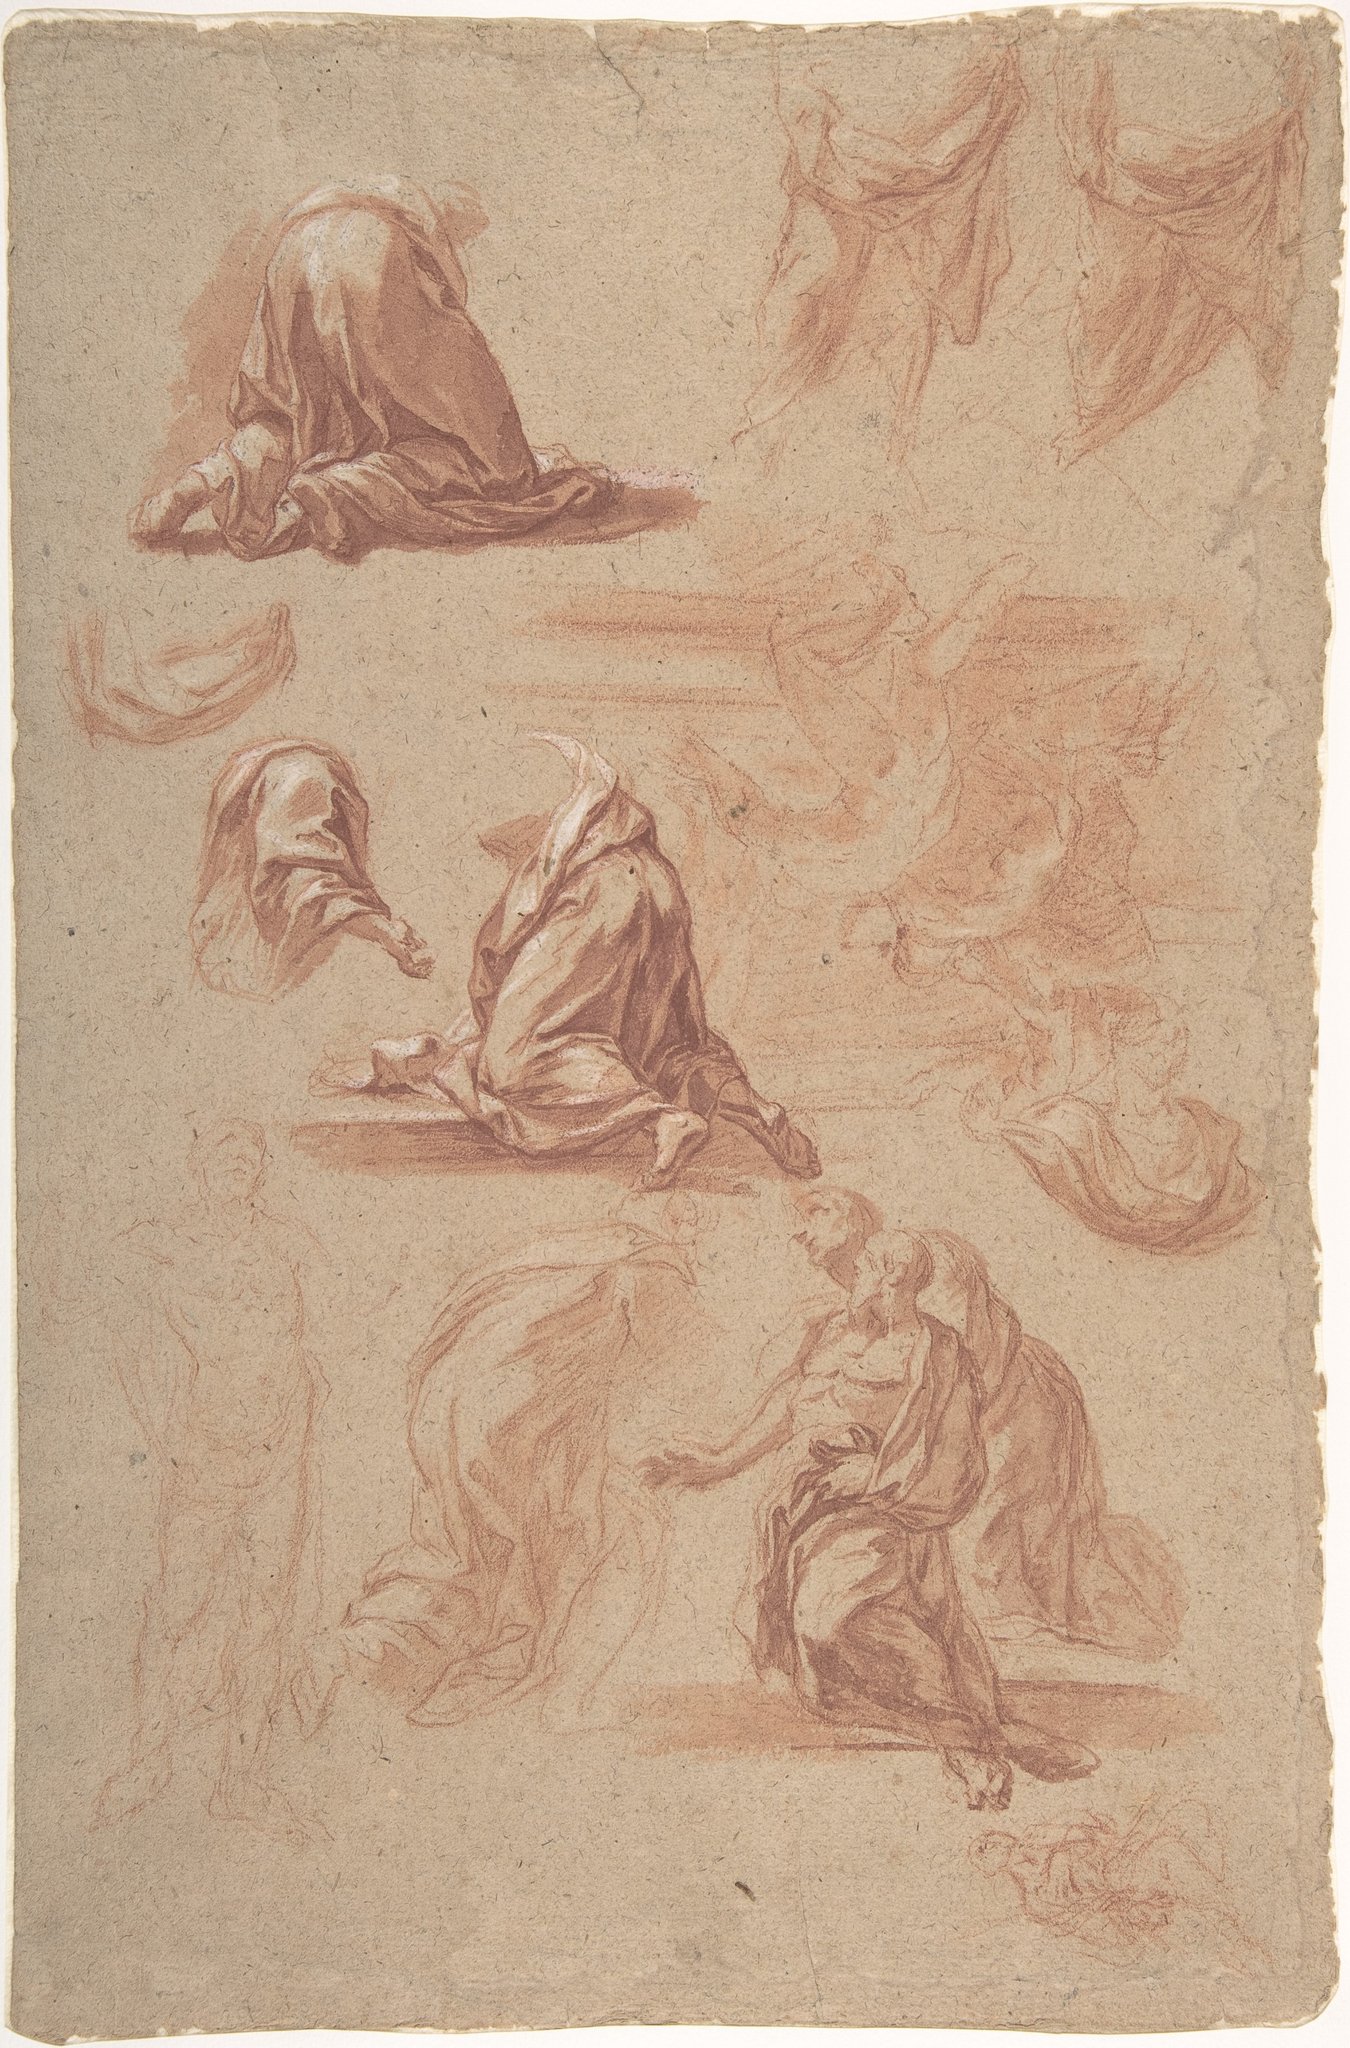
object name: drawing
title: Figural Studies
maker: marco benefial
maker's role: artist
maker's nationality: italian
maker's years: 1684-1764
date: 1684-1764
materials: chalk, paper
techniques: brush, highlighting, wash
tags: hands,men